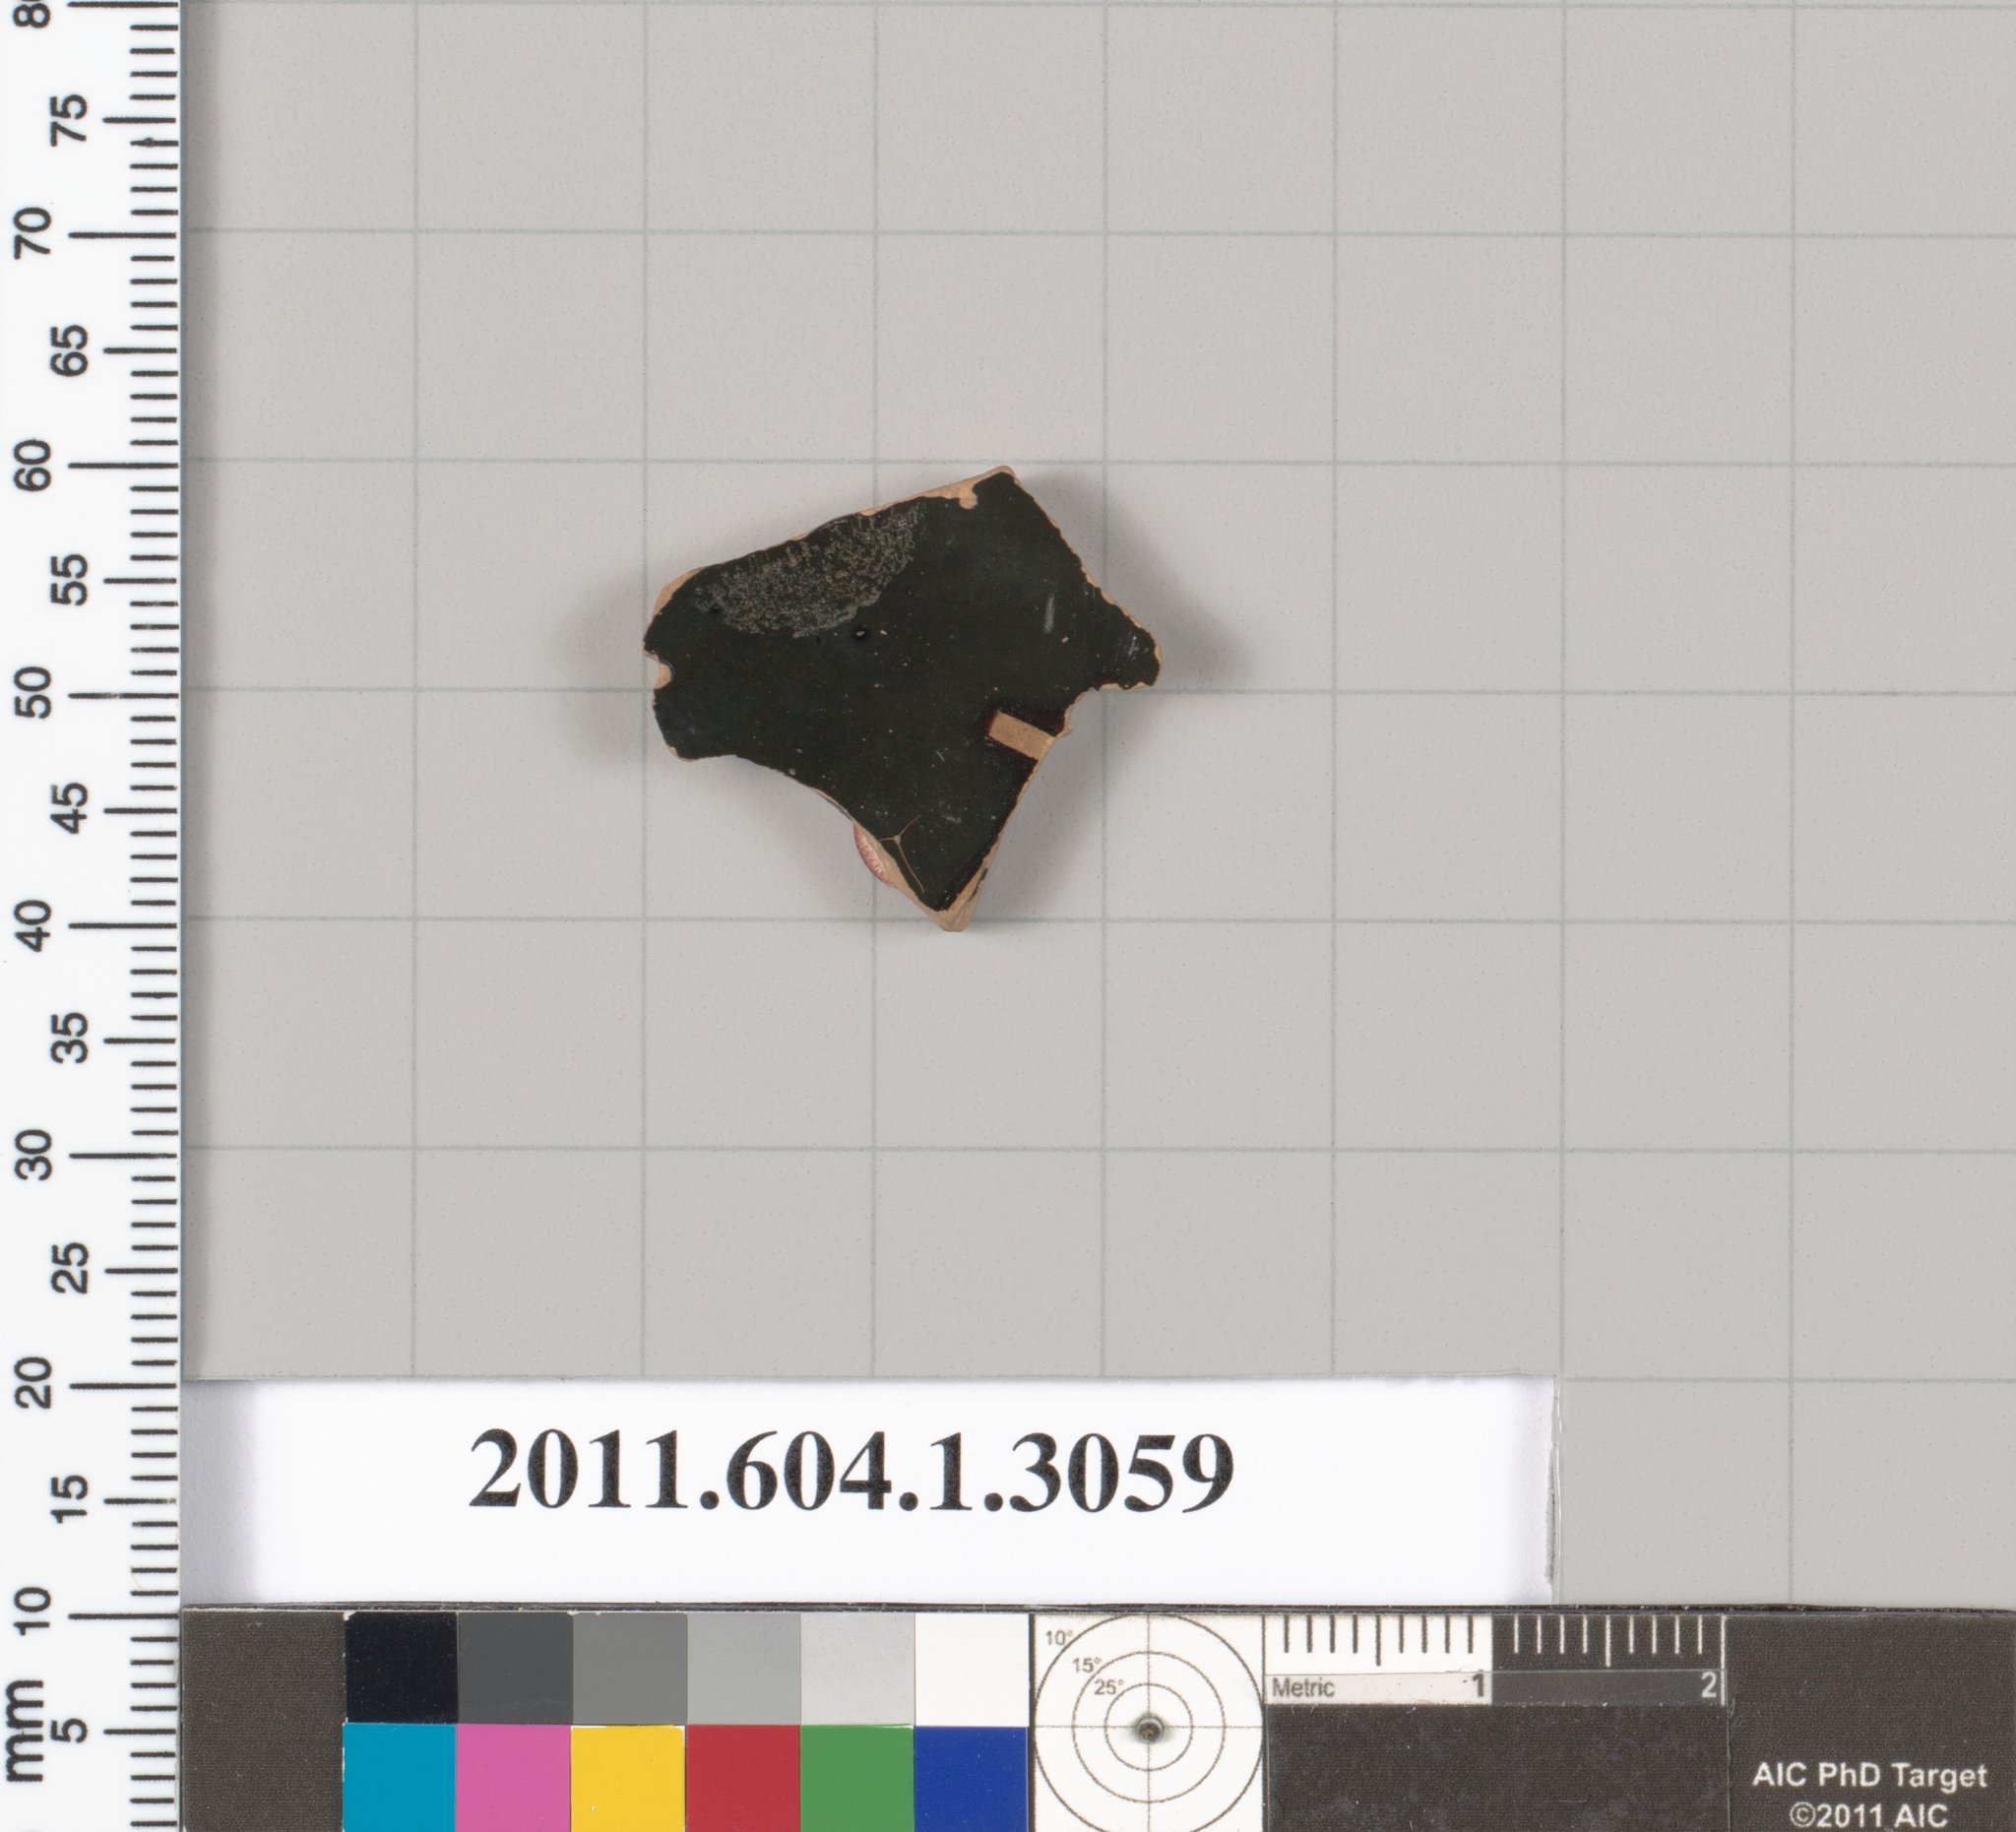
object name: kylix fragment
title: Terracotta fragment of a kylix (drinking cup)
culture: greek, attic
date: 475-451 BCE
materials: terracotta